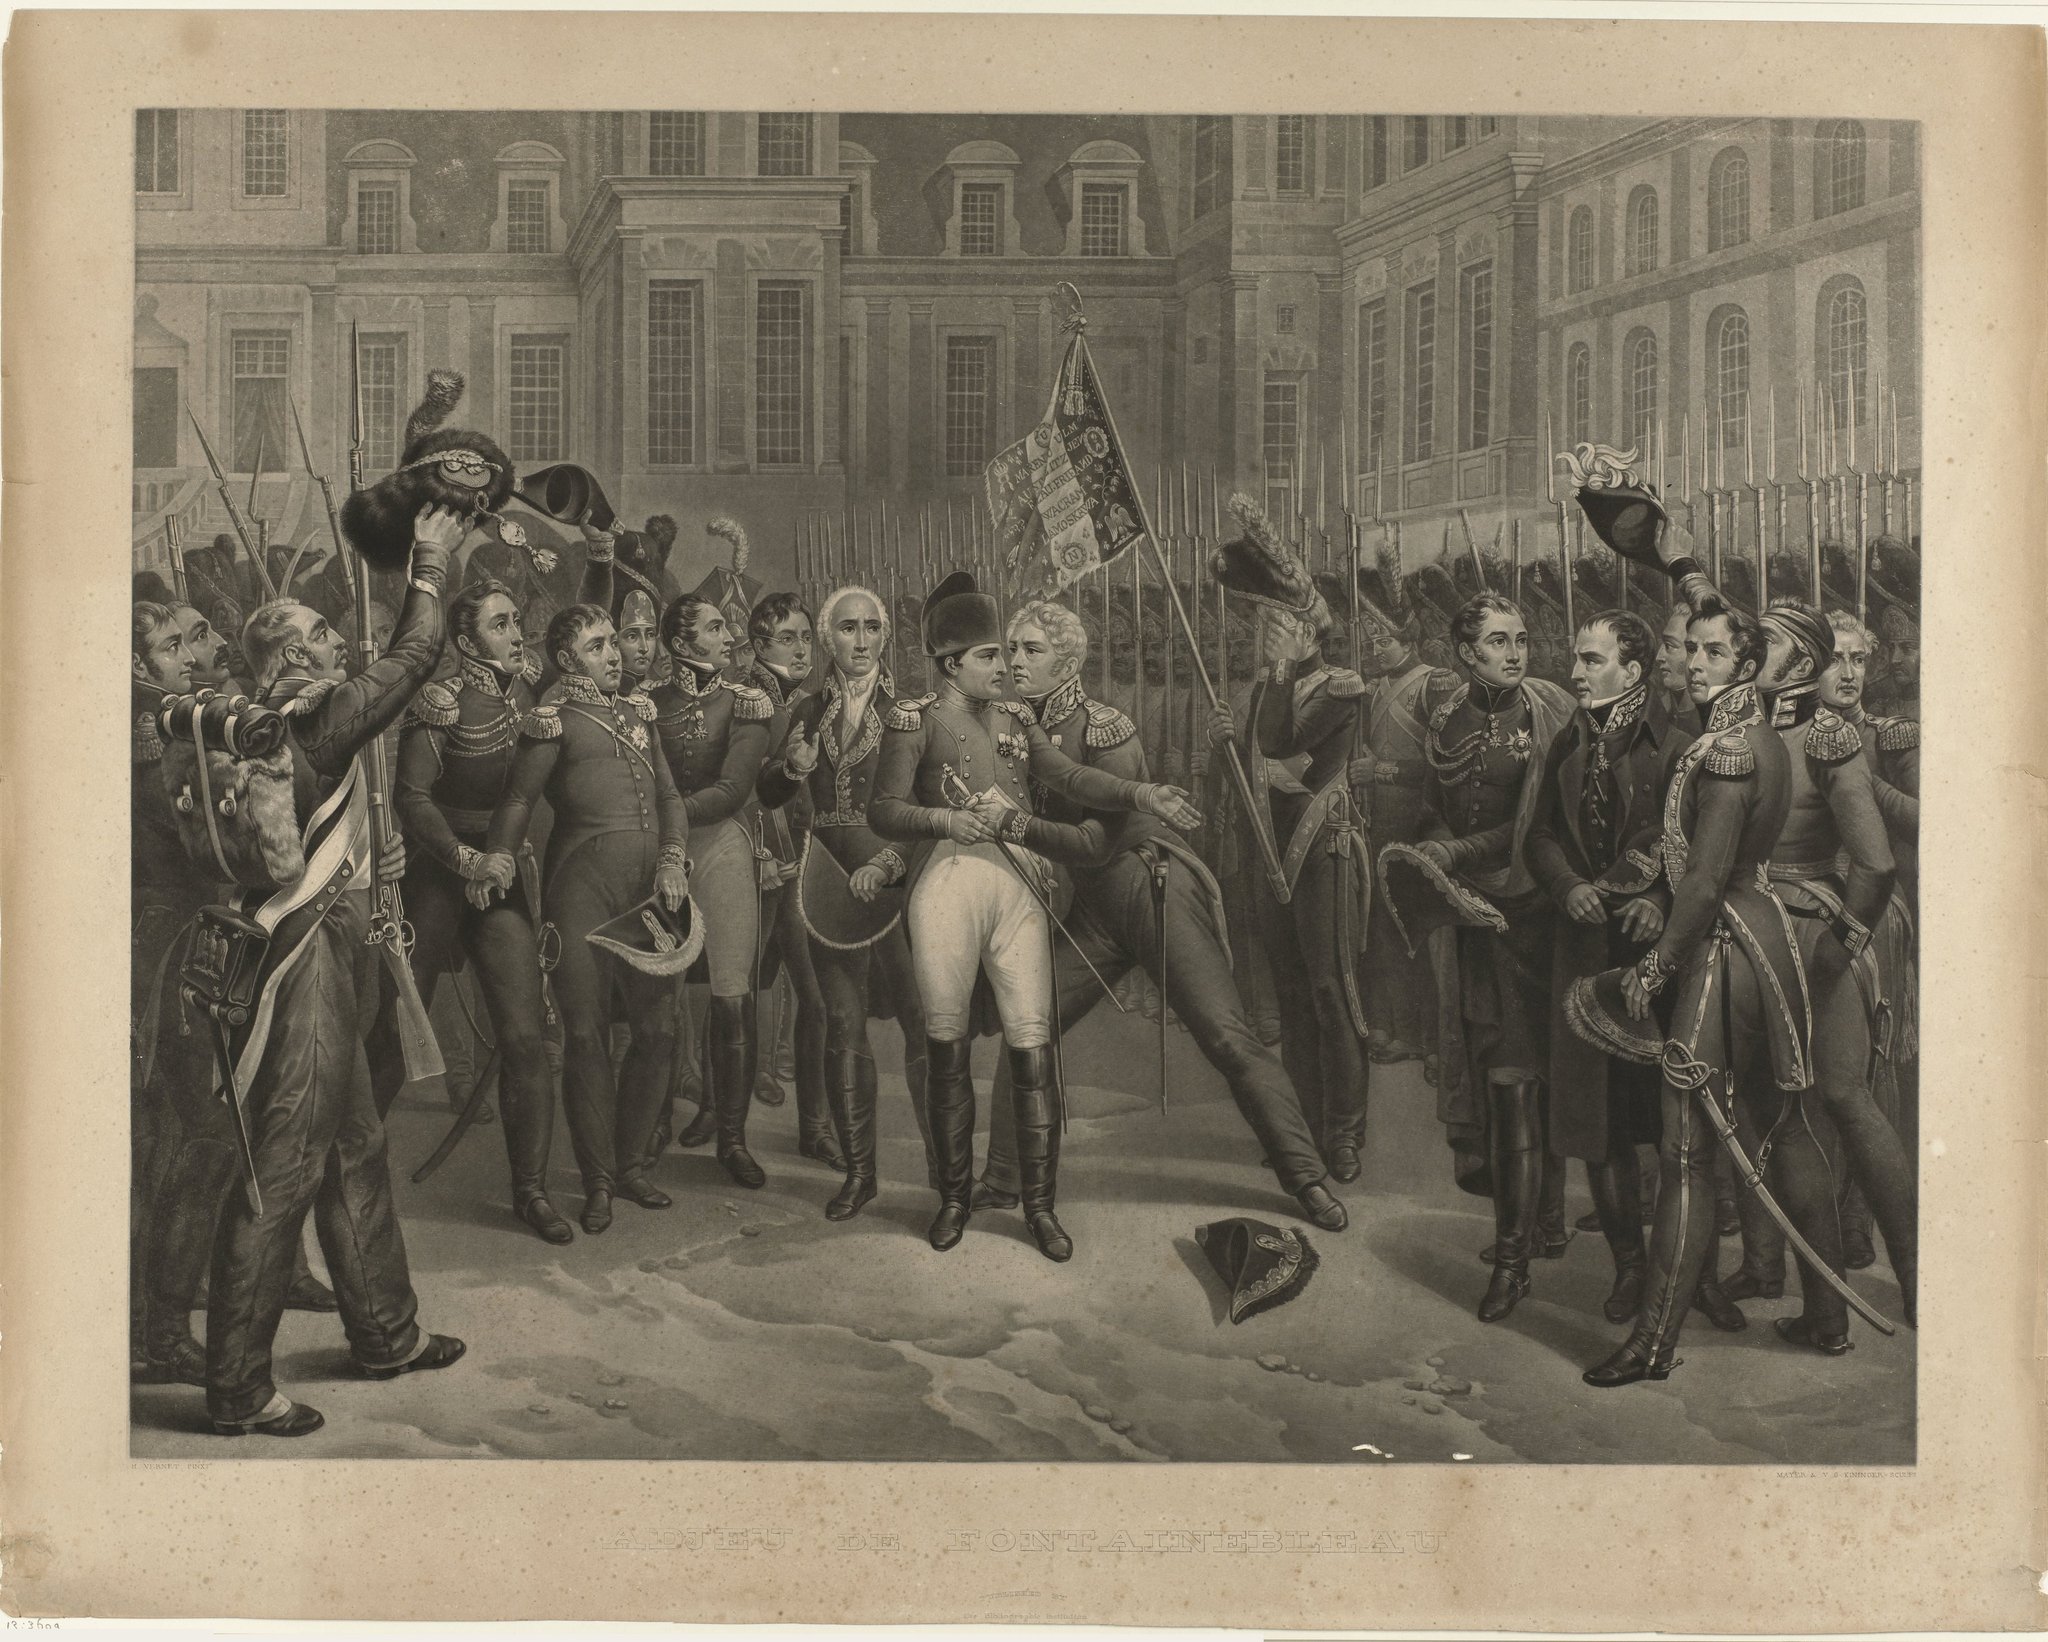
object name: print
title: Adieu de Fontainebleau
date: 1814-1851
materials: paper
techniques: mezzotint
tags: napoleon i (emperor of the french), historical events and situations; historical persons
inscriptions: collector's mark: Lugt 2233